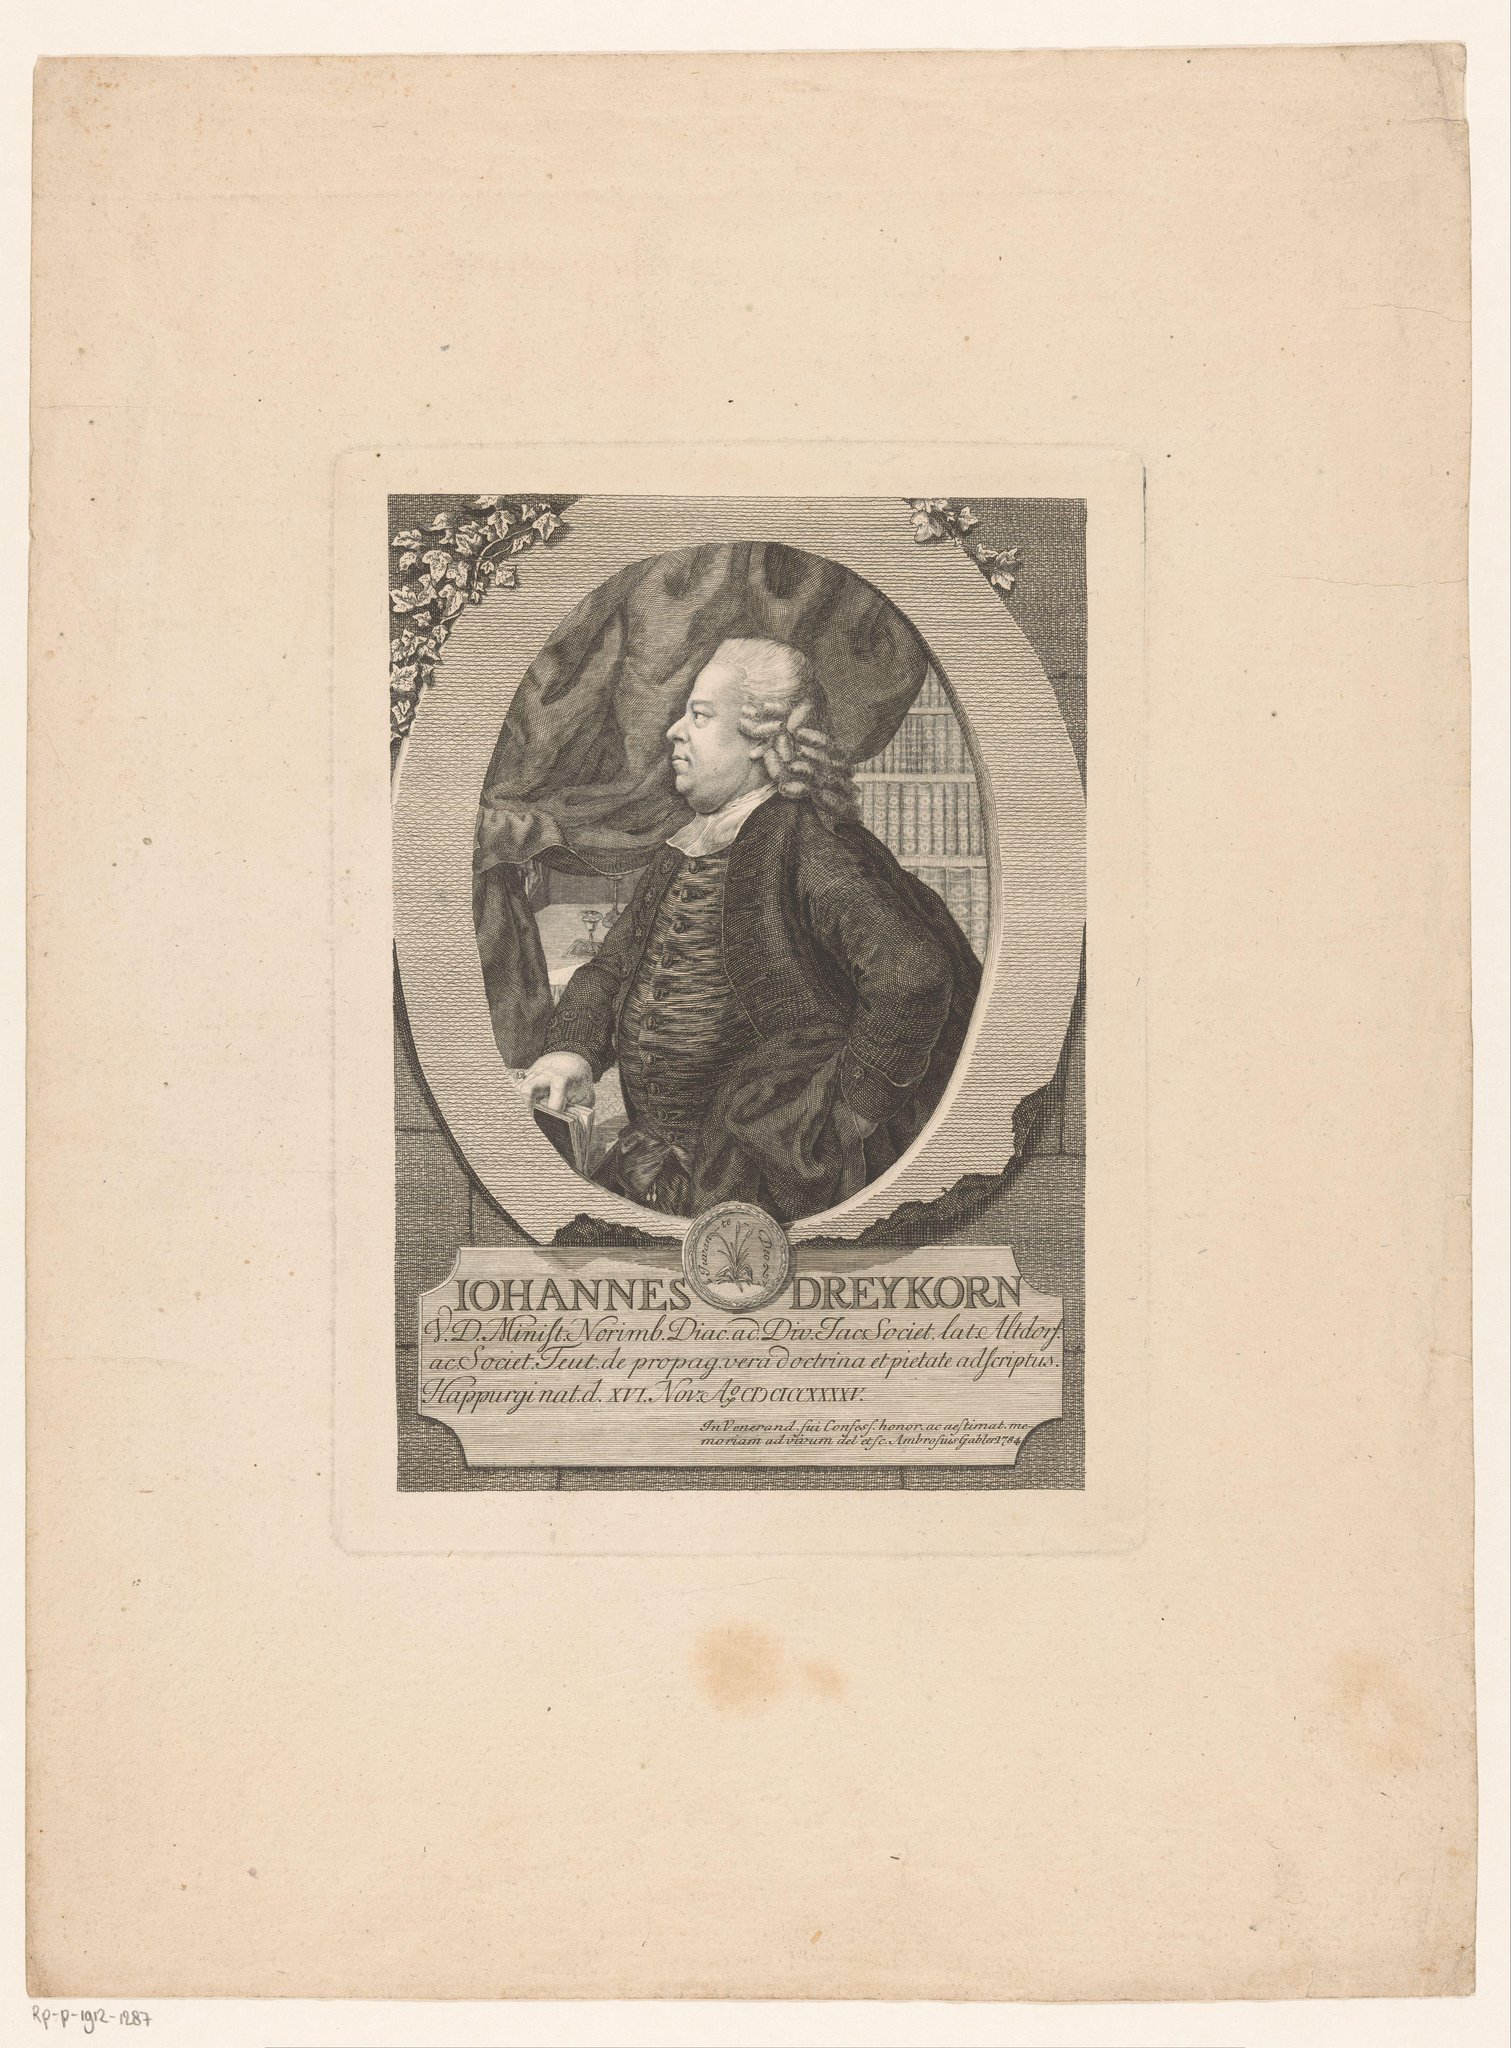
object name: print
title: Portret van Johann Dreykorn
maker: ambrosius gabler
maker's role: print maker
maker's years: 1762-1834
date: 1784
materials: paper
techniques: engraving, etching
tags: bookshelves, ornament ~ medallion, historical persons, book, abstract ideas and concepts (+ emblematical representation of concept)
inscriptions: collector's mark: Lugt 2228